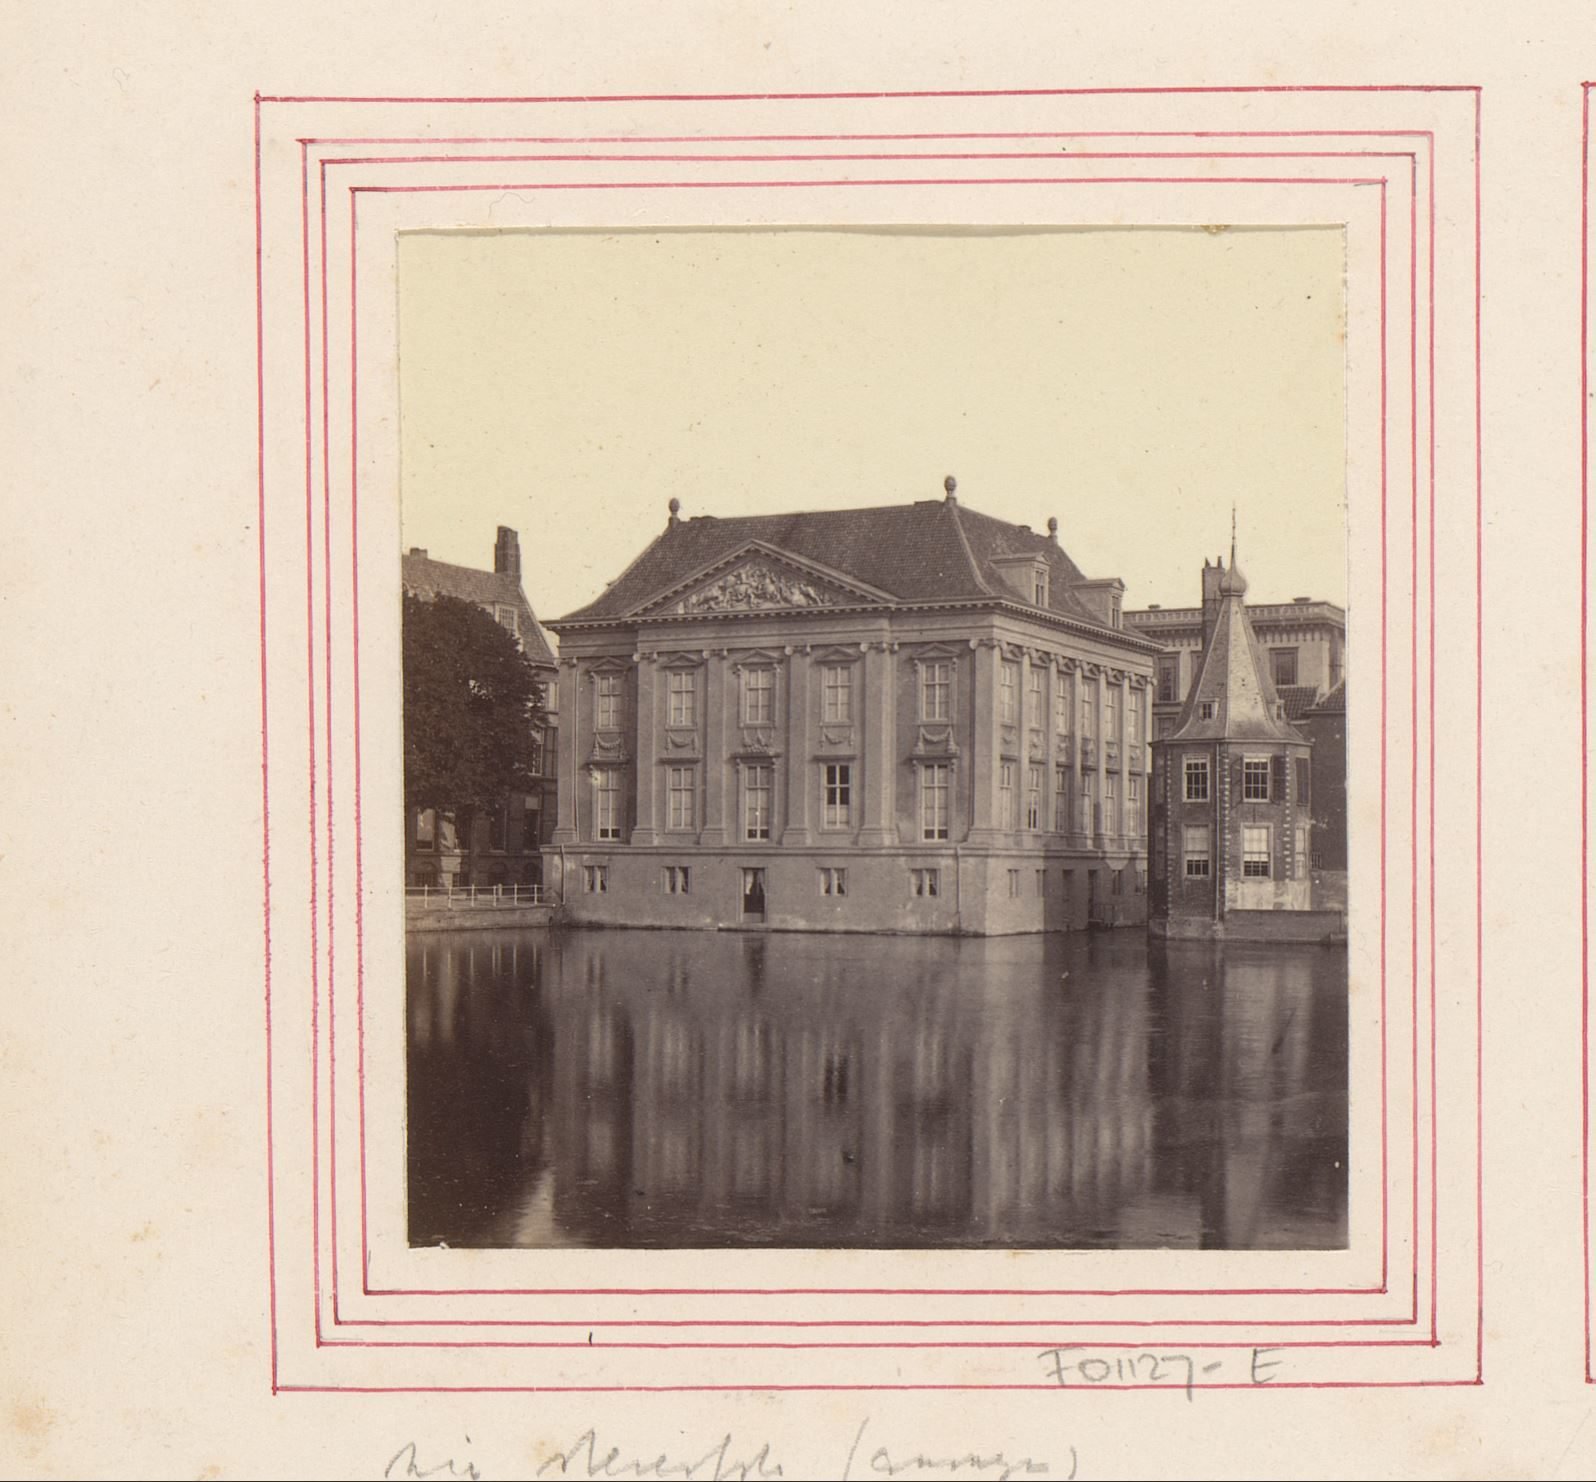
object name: photograph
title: Hofvijverzijde van het Mauritshuis en het Torentje in Den Haag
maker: Anonymous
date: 1870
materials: photographic support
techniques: albumen print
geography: the hague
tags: palace, permanent exhibition, museum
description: Onderdeel van Album met foto's en litho's van bezienswaardigheden in Noord- en Zuid-Hollandse steden, schilderijen en klederdrachten.